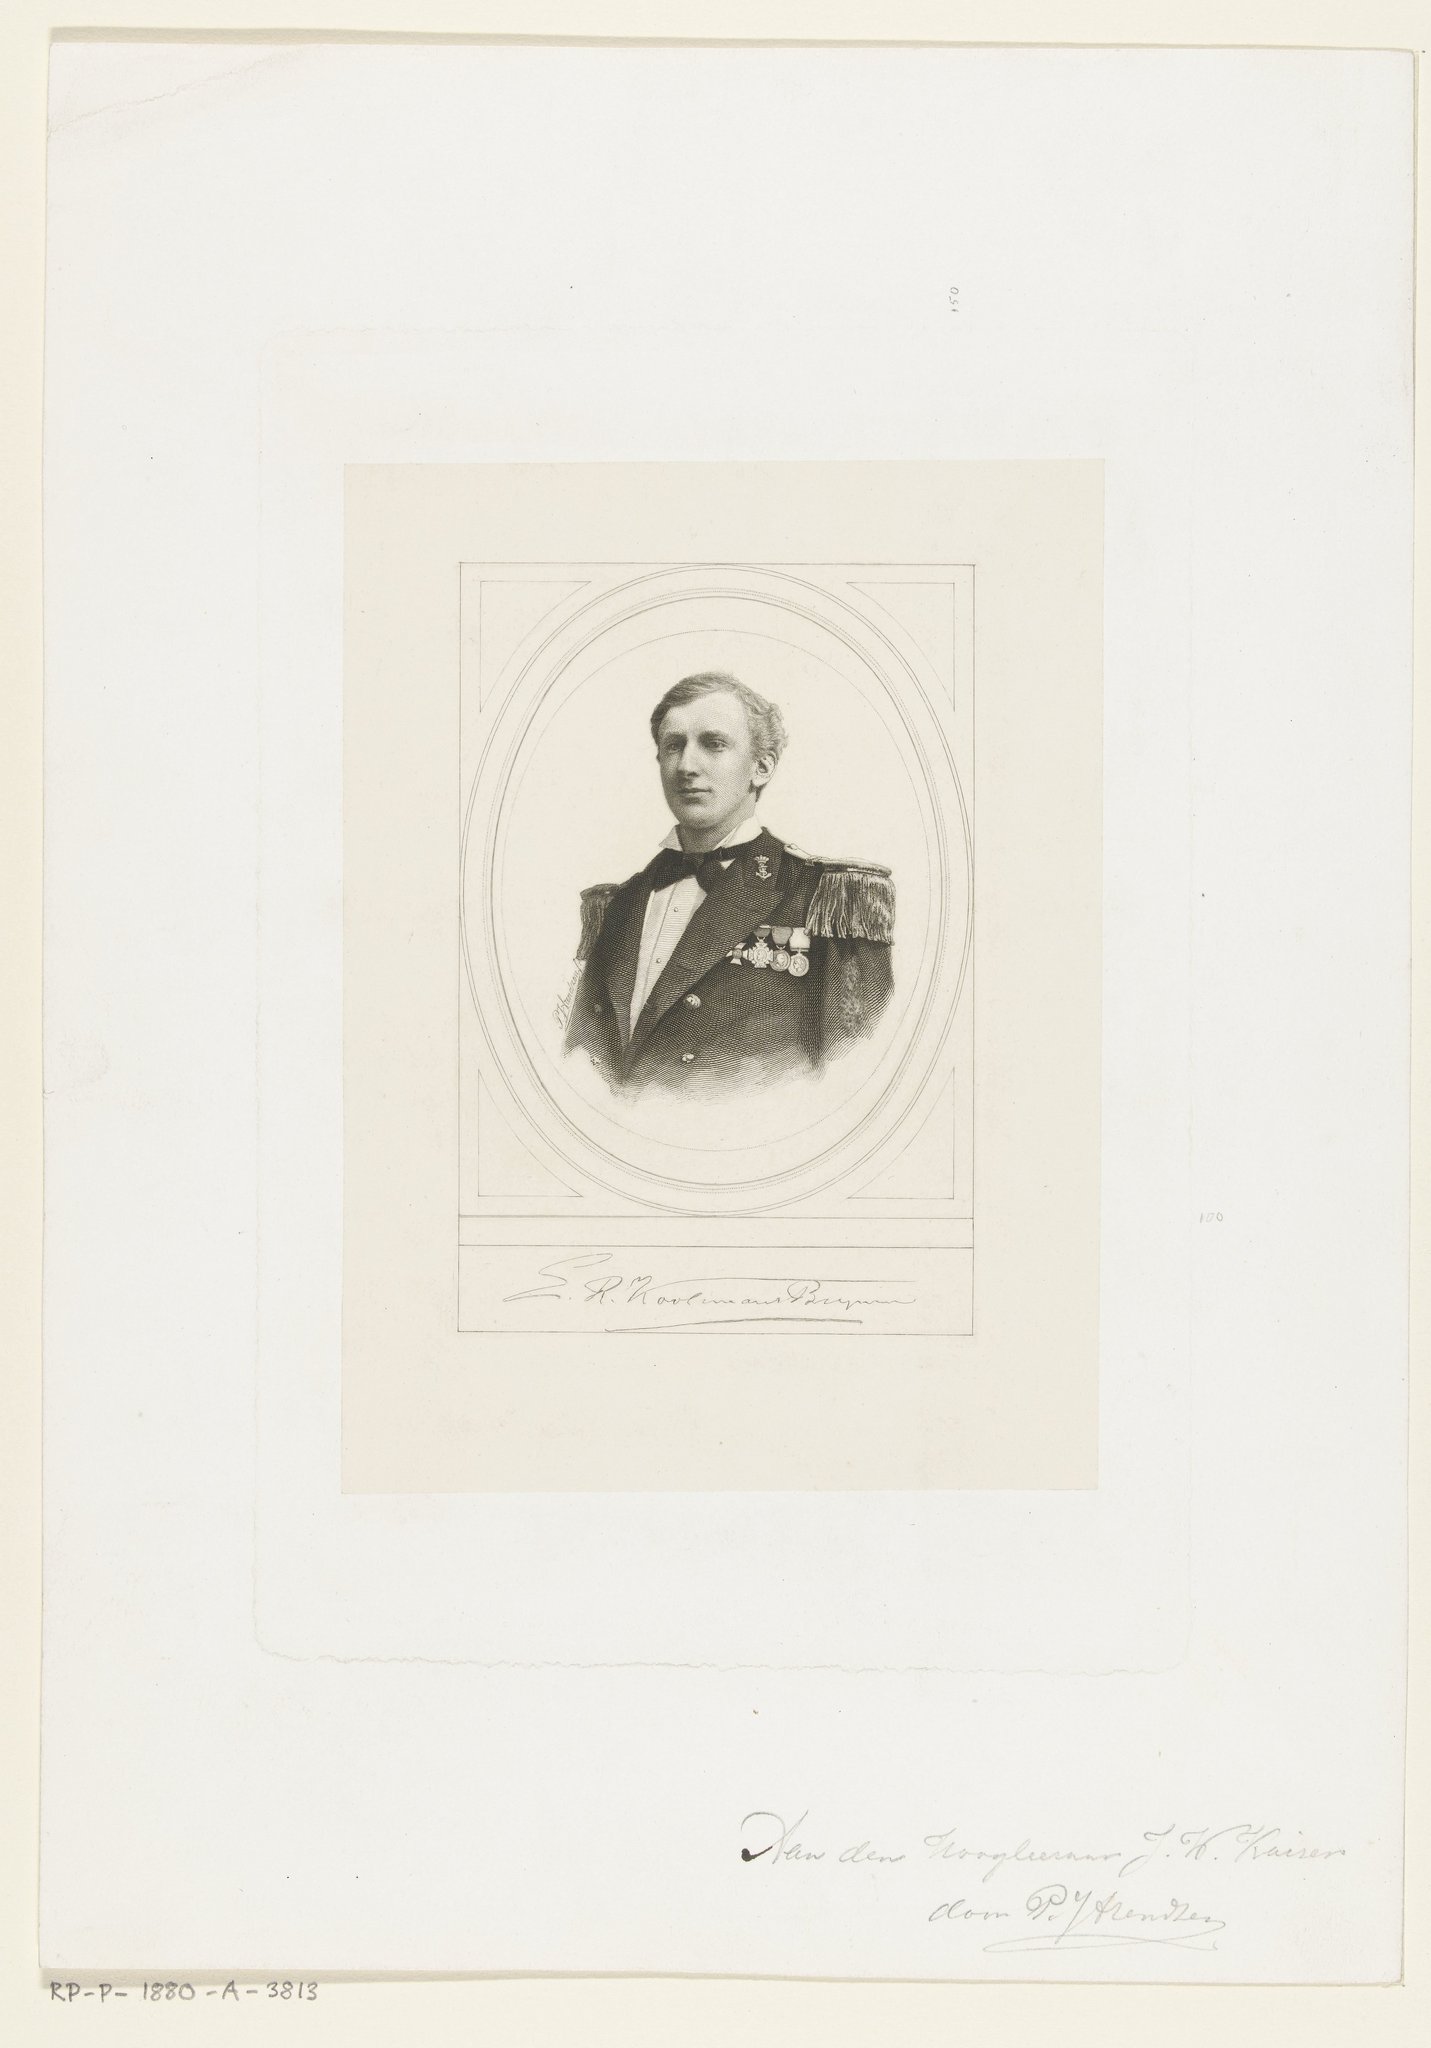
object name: print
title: Portret van L.R. Koolemans Beynen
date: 1870-1880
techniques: printmaking, engraving, etching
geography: netherlands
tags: traveler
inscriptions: collector's mark: Lugt 2228, inscription: ‘Aen den hoogleeraar J.W. Kaiser door P.J. Arendzen’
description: Borstbeeld van L.R. Koolemans Beynen in marine-uniform. Onder het portret een facsimile van zijn handtekening.